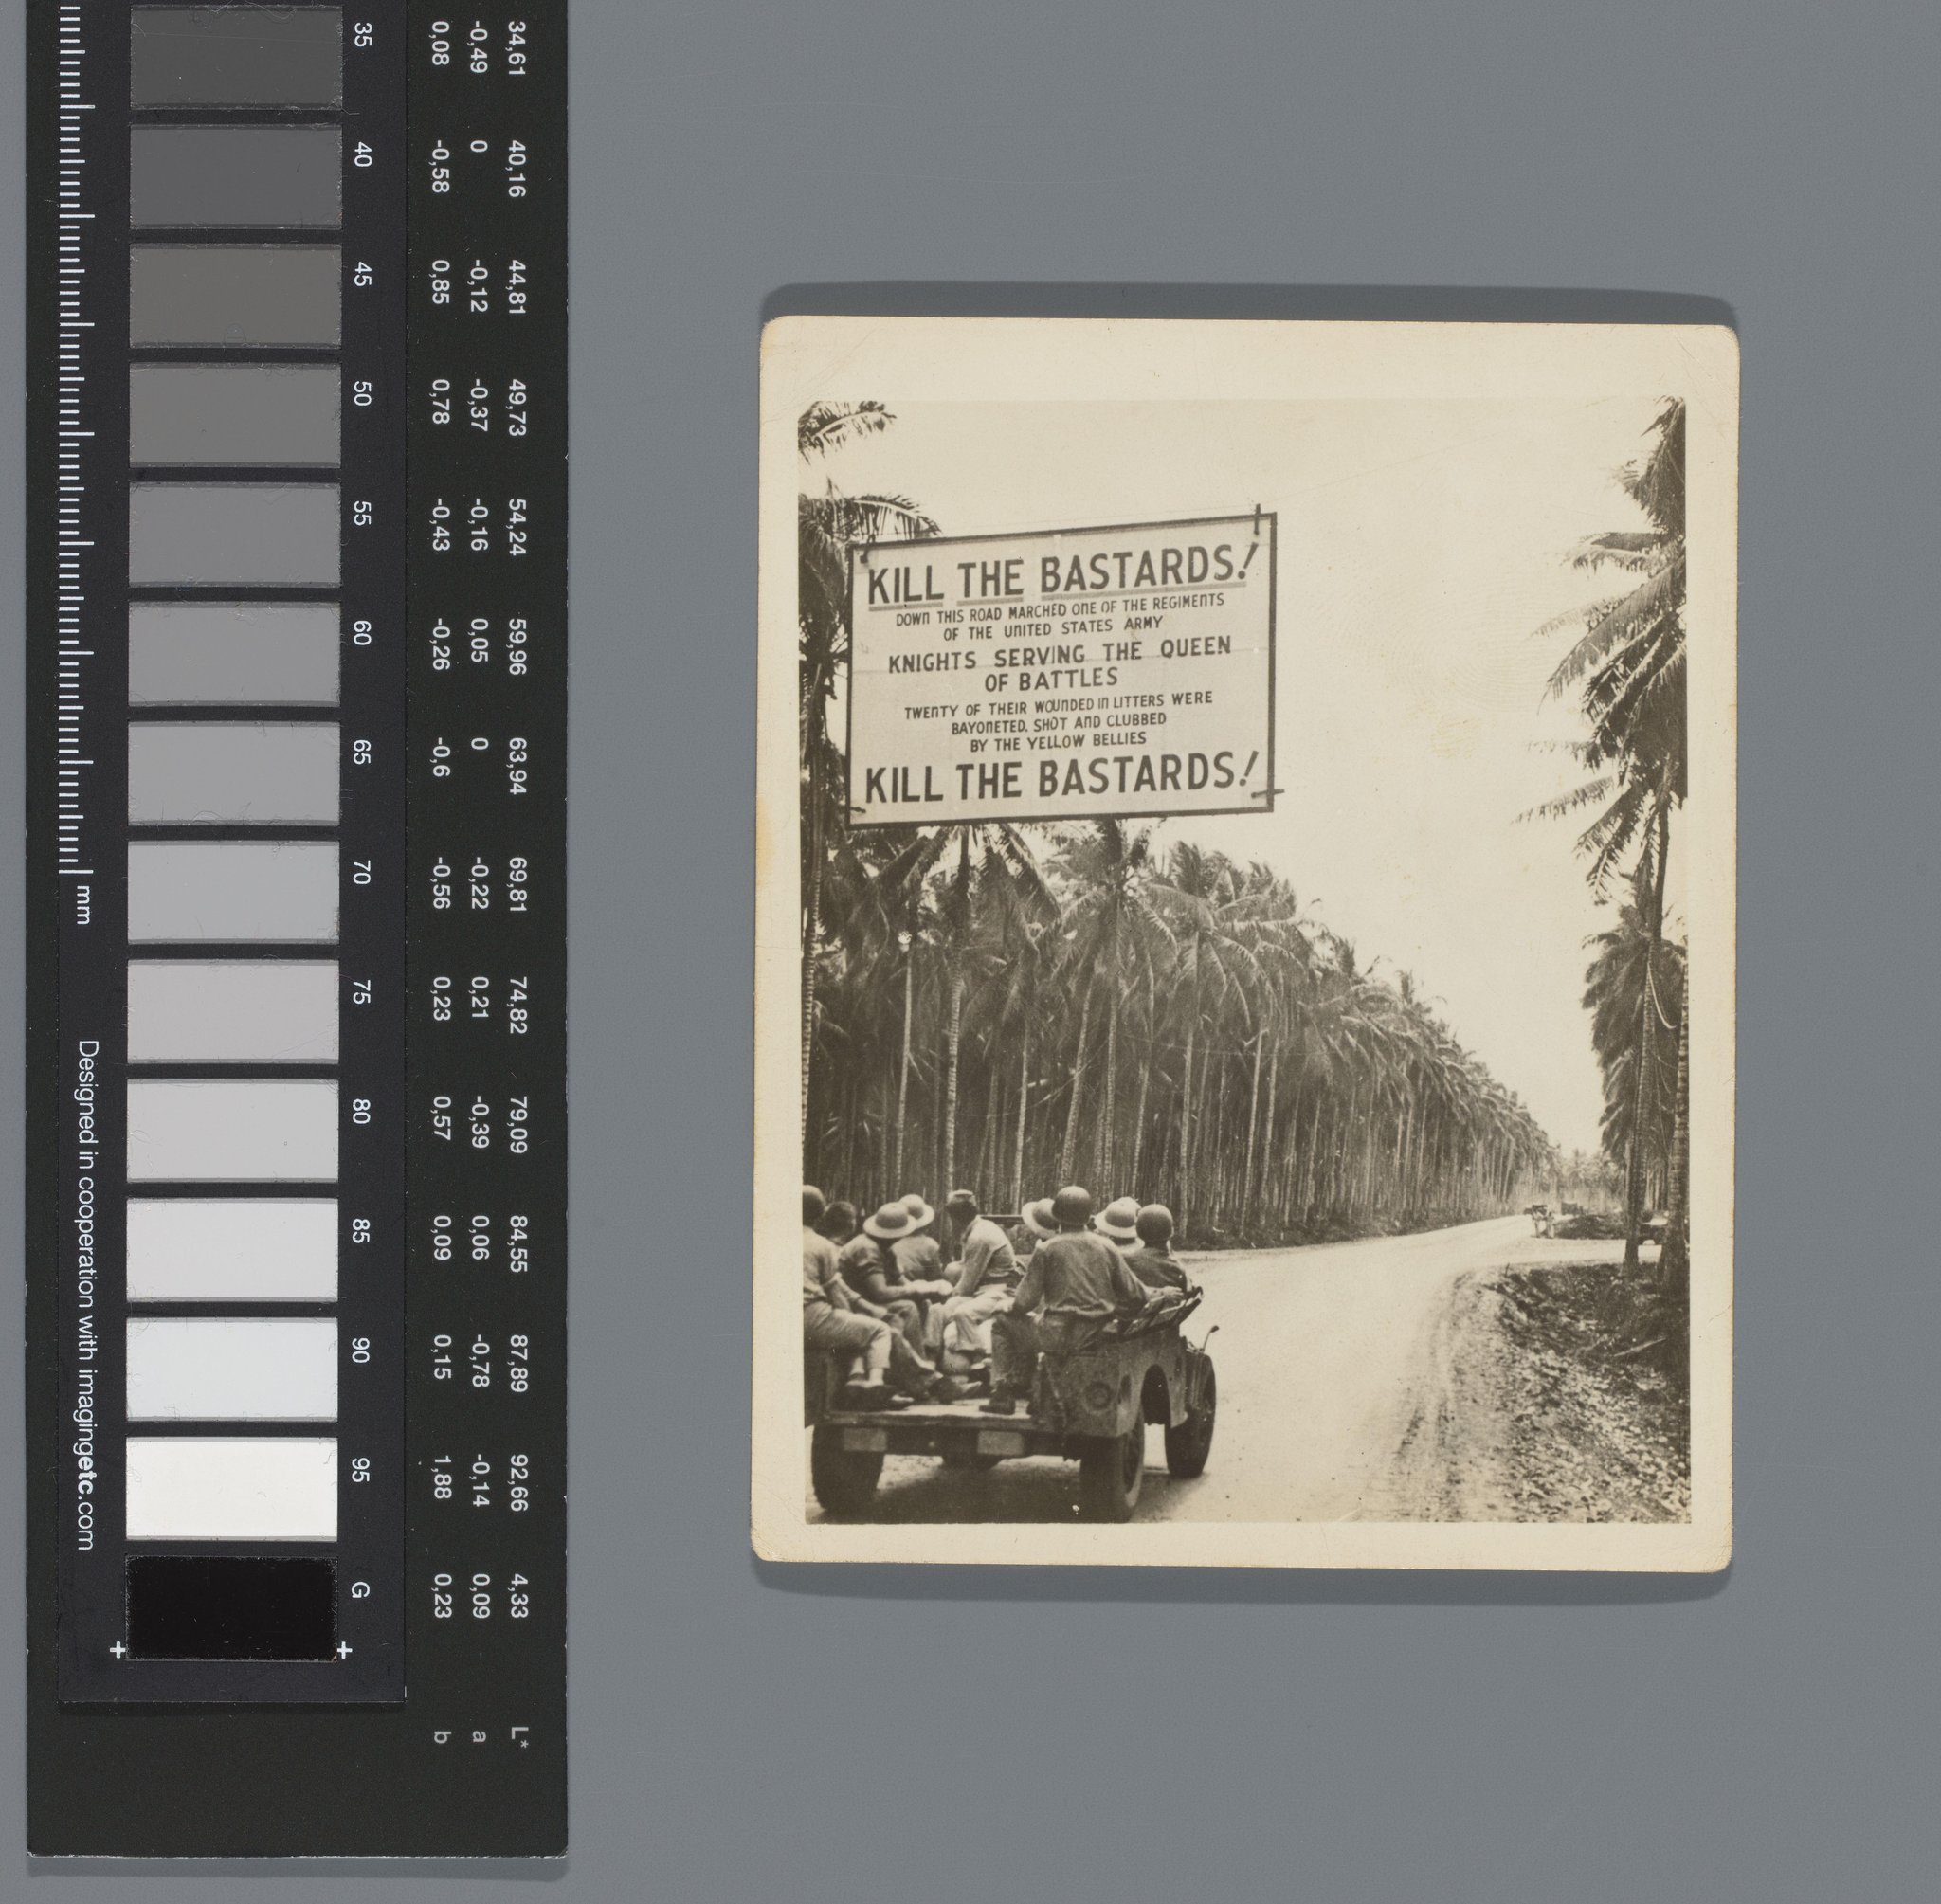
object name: photograph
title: Jeep met Amerikaanse soldaten, met boven de weg een spandoek met anti-Japanse leuzen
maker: Anonymous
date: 1944-1945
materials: paper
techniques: gelatin silver print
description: Boven de jeep hangt een spandoek met de tekst: ‘KILL THE BASTARDS! / DOWN THIS ROAD MARCHED ONE OF THE REGIMENTS / OF THE UNITED STATES ARMY / KNIGHTS SERVING THE QUEEN OF BATTLES / TWENTY OF THEM WOUNDED IN LITTERS WERE / BAYONETED, SHOT AND CLUBBED / BY THE YELLOW BELLIES / KILL THE BASTARDS!